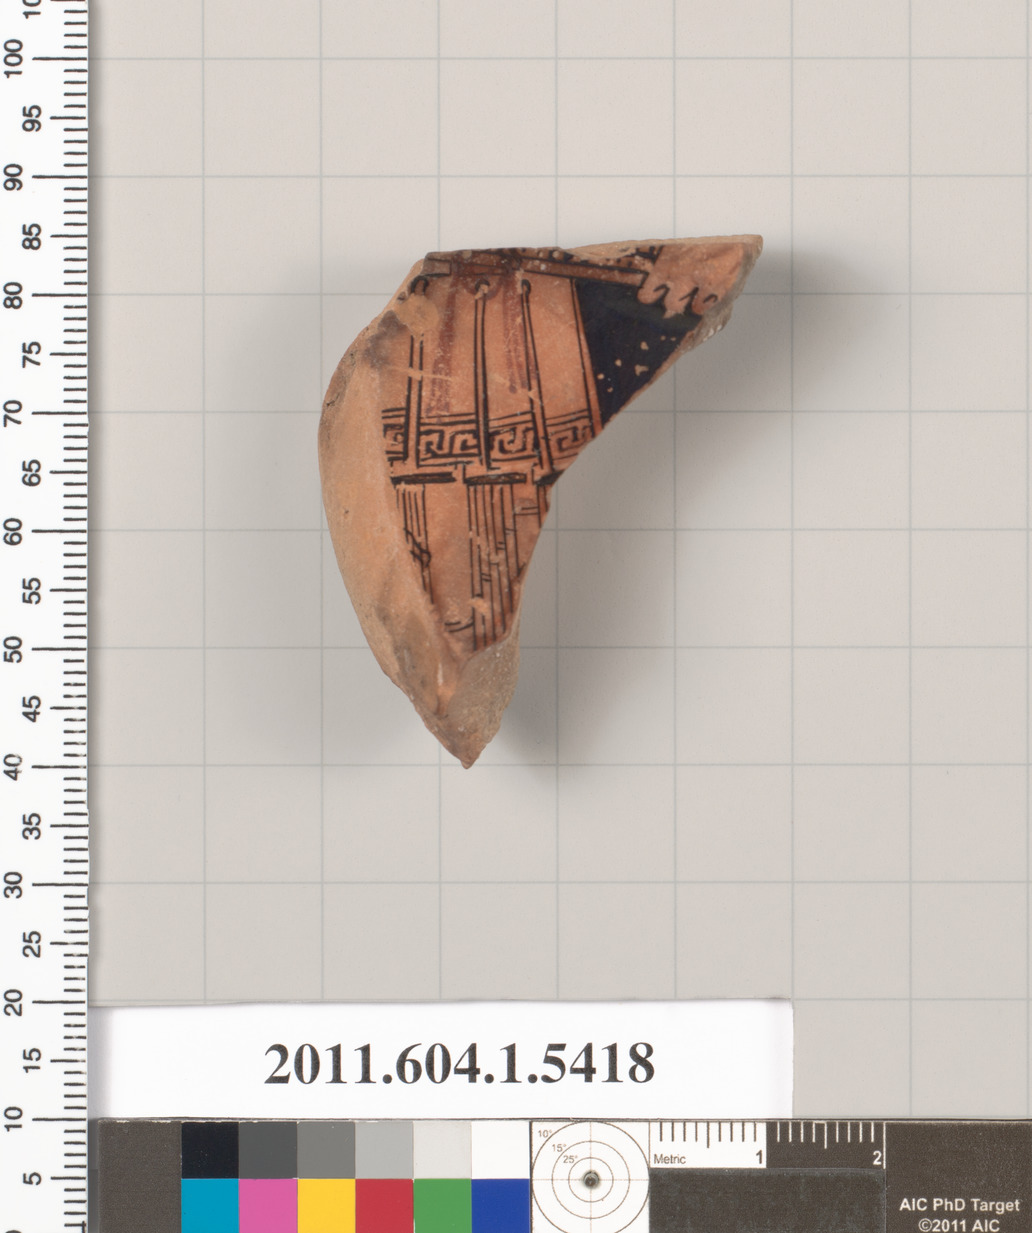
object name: kylix fragment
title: Terracotta fragment of a kylix (drinking cup)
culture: greek, attic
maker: apollodoros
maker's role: artist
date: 567-600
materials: terracotta